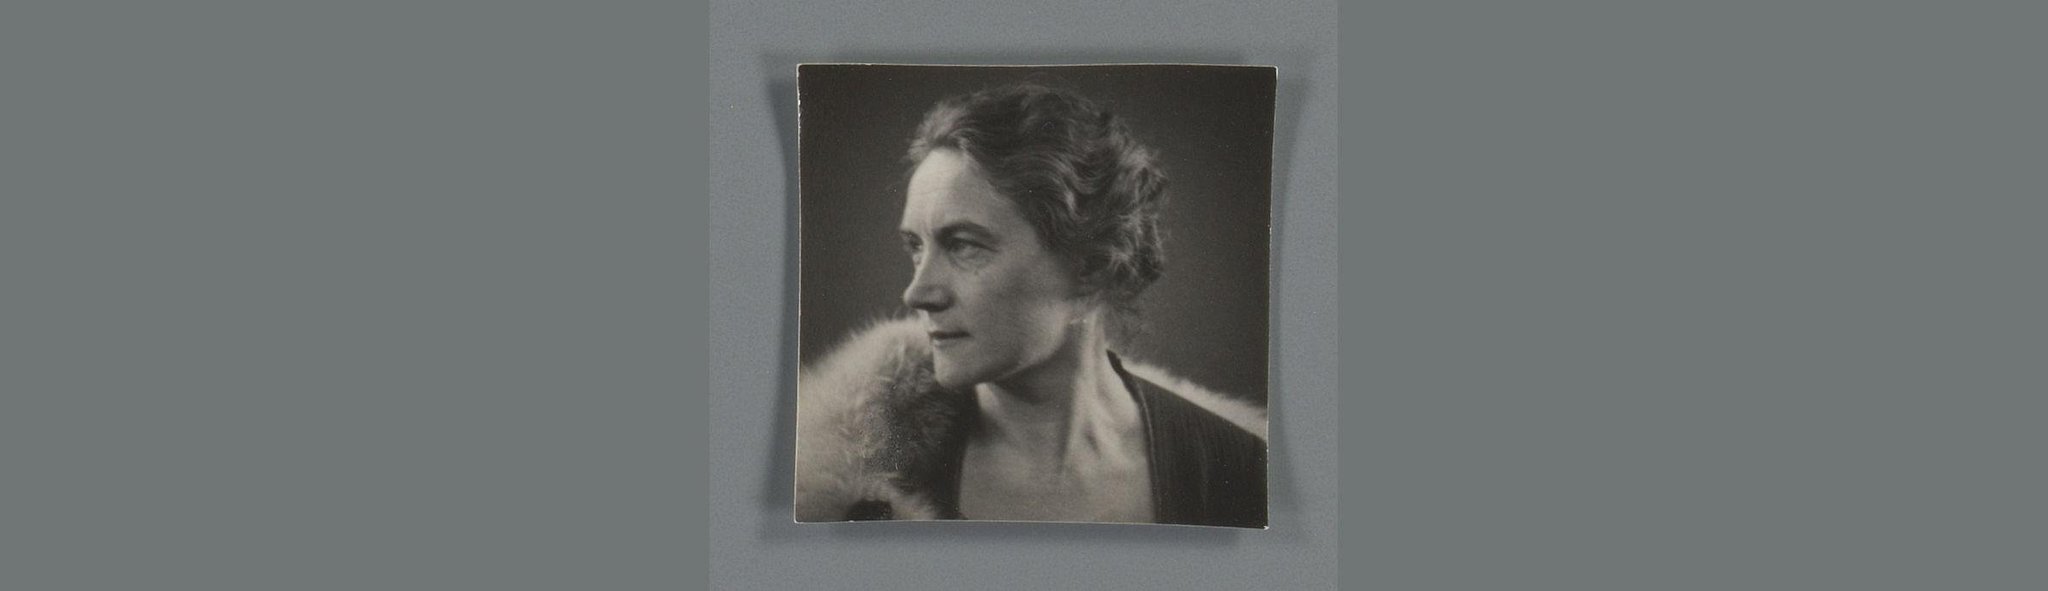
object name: snapshot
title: Portret van Johanna (Hans) de Jong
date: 1903-1940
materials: paper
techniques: gelatin silver print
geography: the hague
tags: johanna petronella lambertina stokhuyzen-de jong (hans), historical persons - bb - woman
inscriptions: number: ‘18’